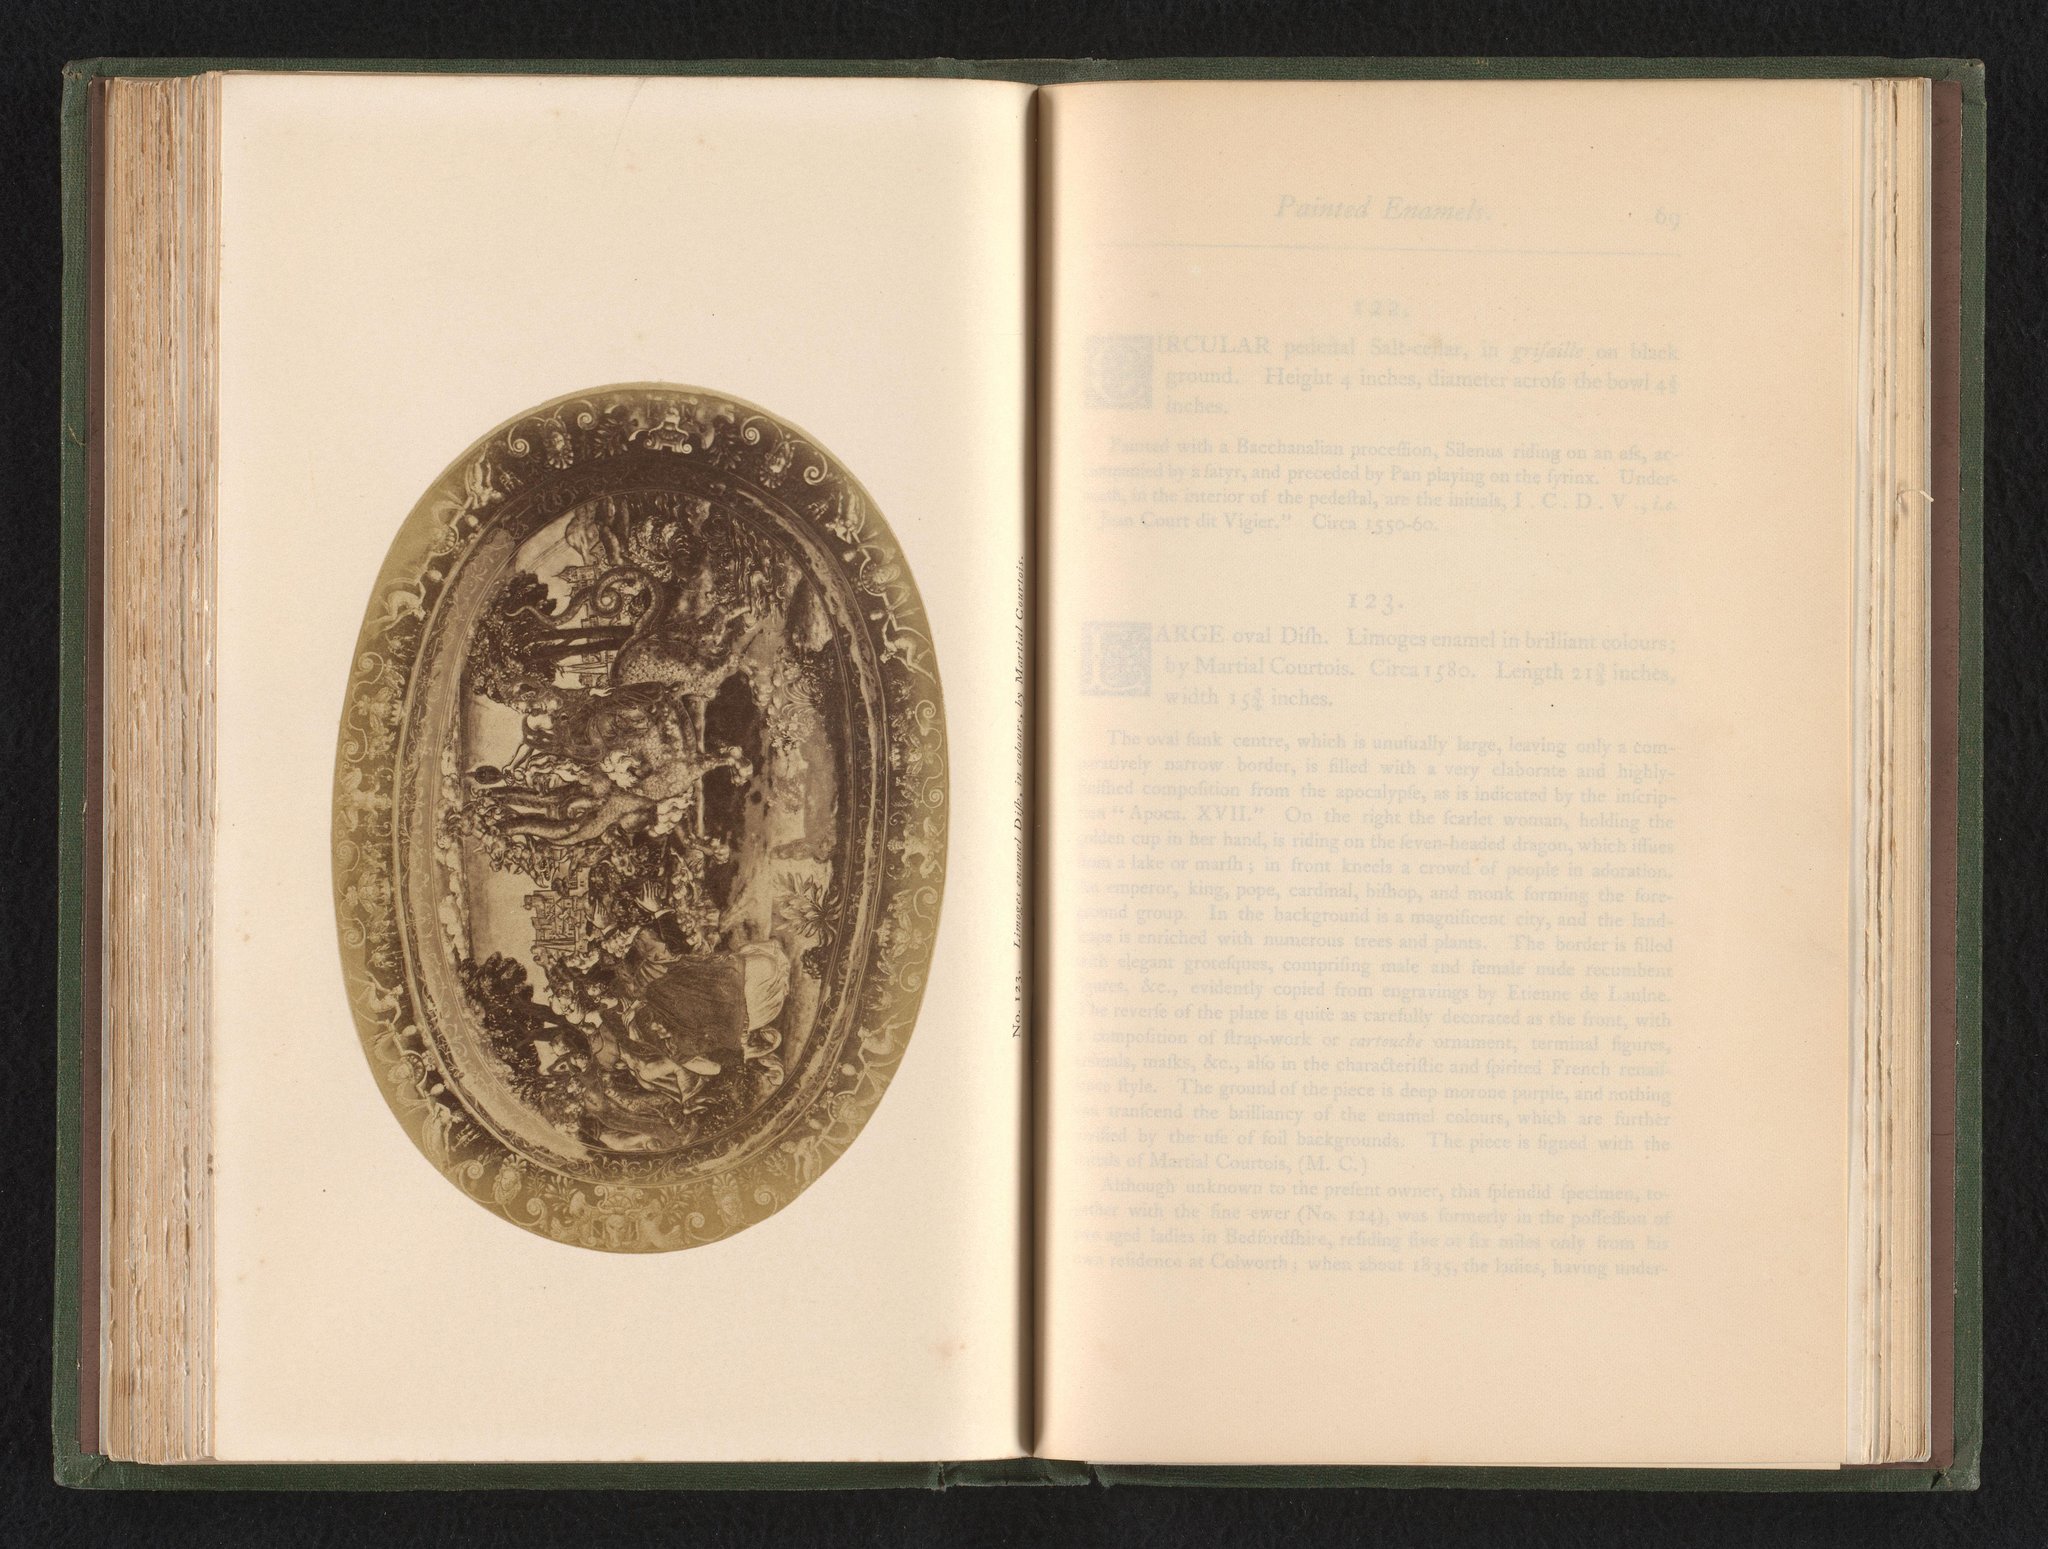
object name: page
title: Limoges enamel Dish, in colours, by Martial Courtois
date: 1851-1861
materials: paper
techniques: albumen print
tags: enamelling ~ applied arts, dish, plate, saucer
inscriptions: number: ‘No. 123.’